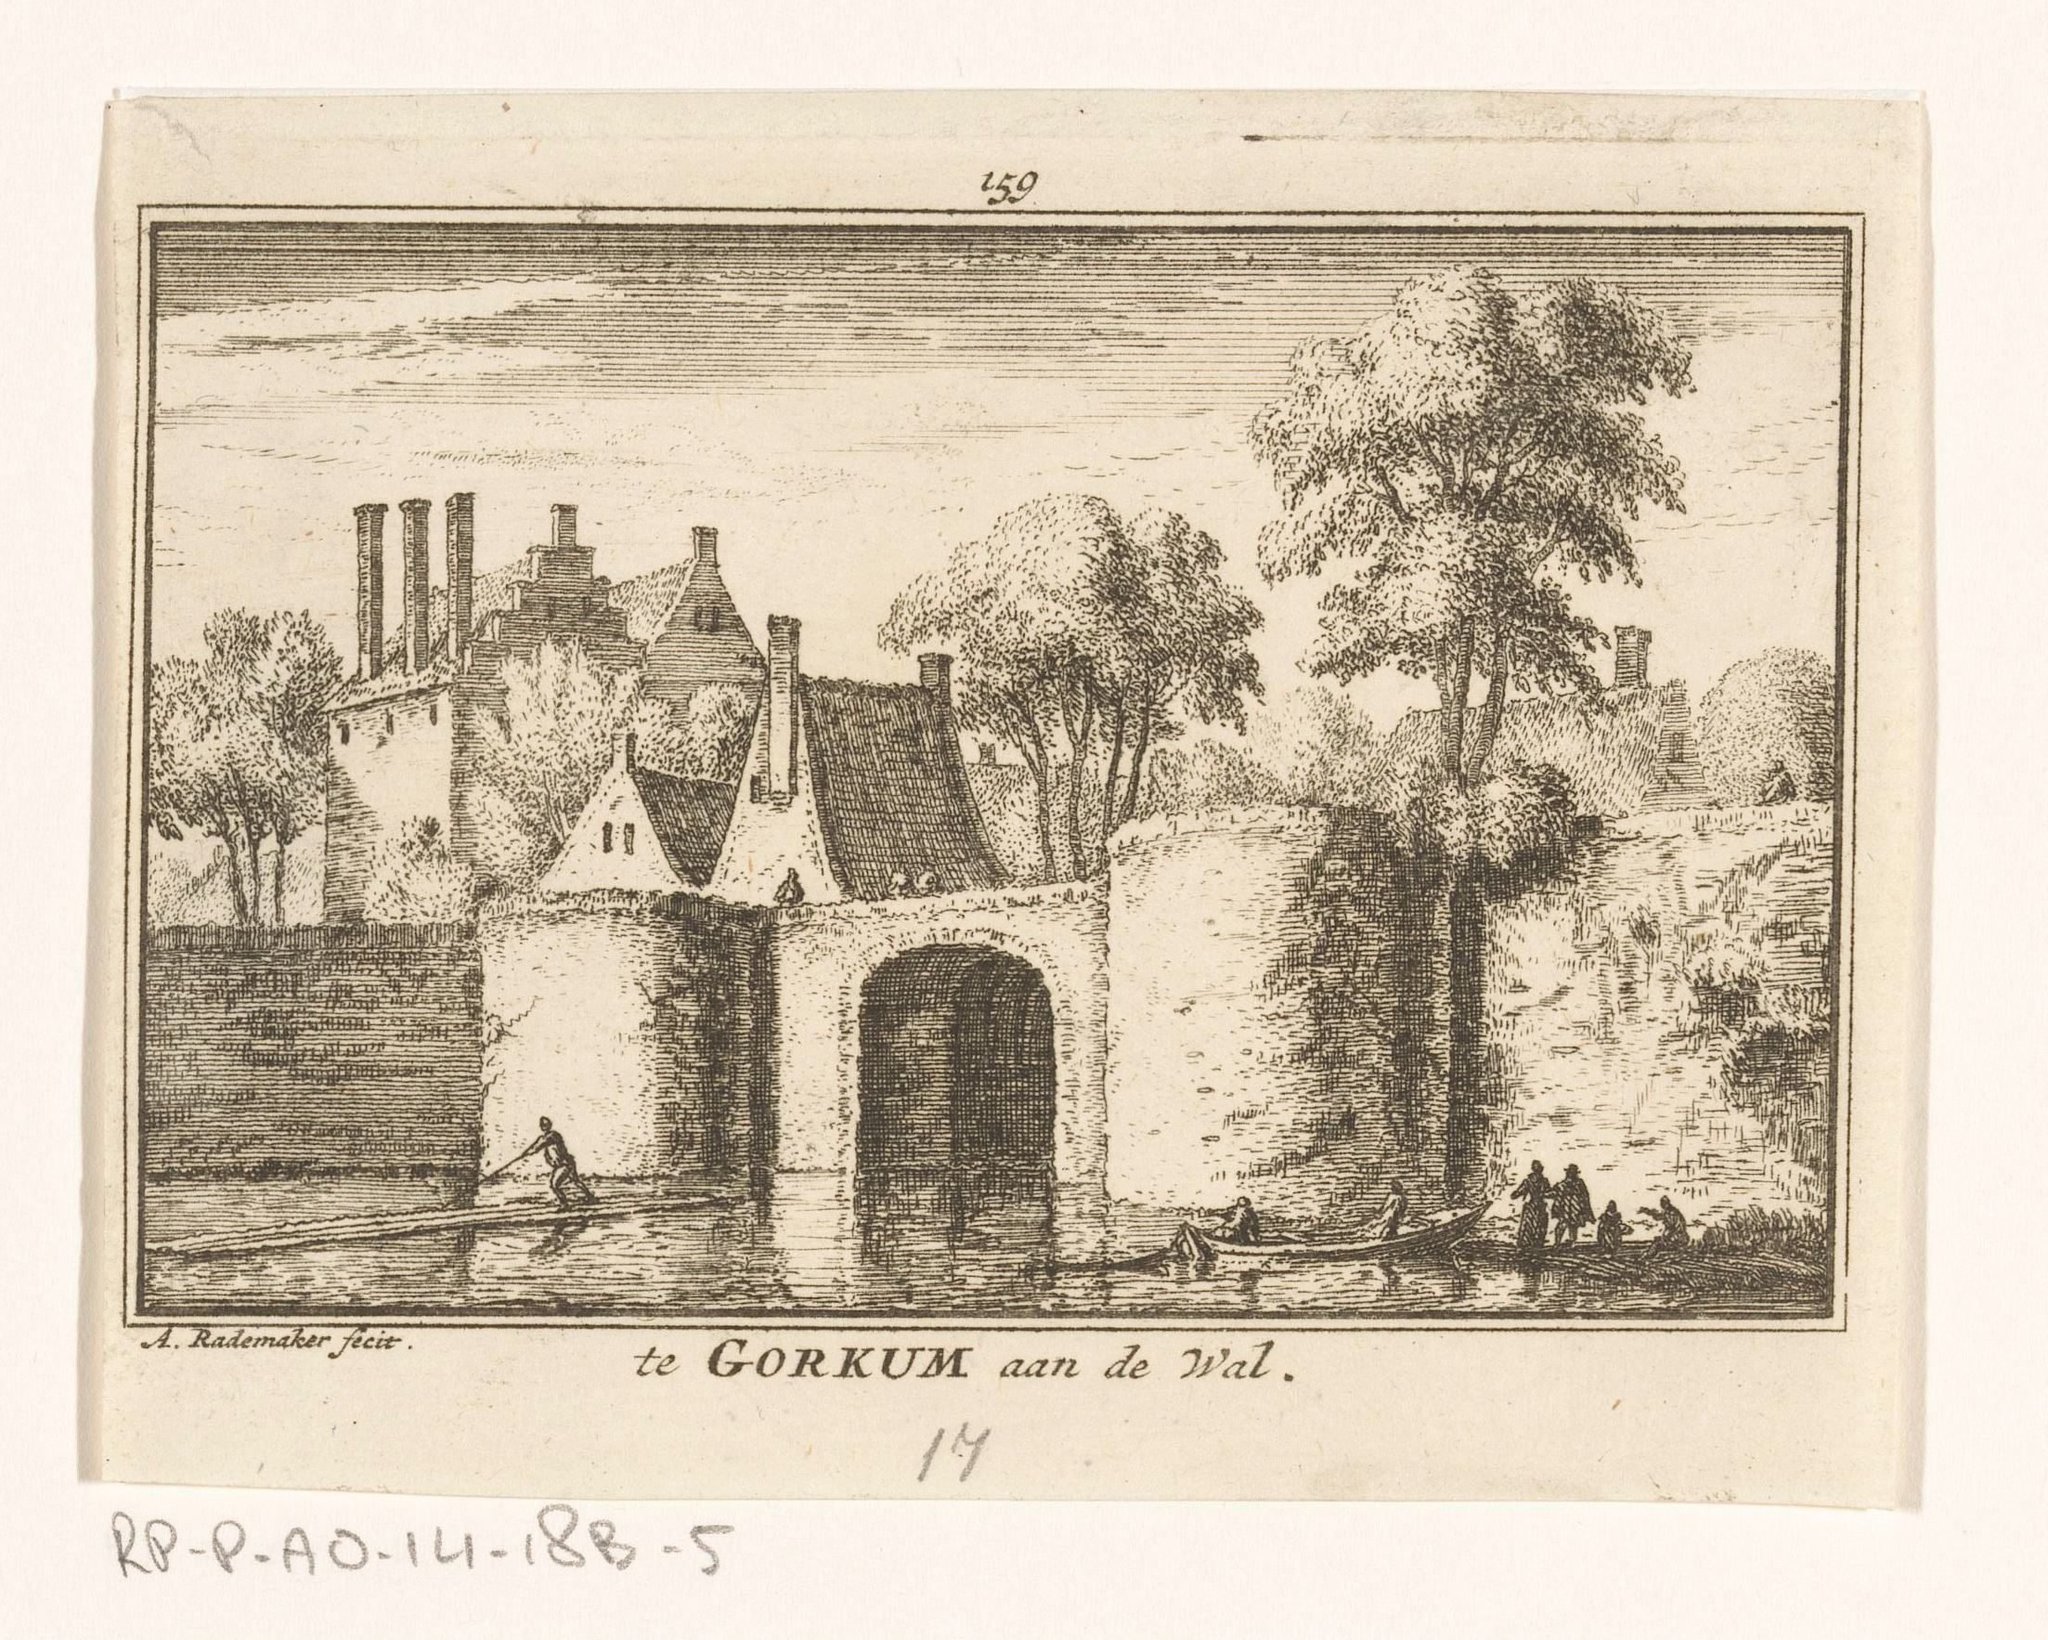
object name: book illustration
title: Gezicht op de vestingwal van Gorinchem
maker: abraham rademaker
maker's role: draughtsman, print maker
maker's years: 1676-1735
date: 1725-1803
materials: paper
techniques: engraving, etching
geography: amsterdam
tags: rowing-boat, canoe, etc., city-walls, walls ~ fortified city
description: Prent ook gebruikt in: Rademaker, Abraham. Kabinet van Nederlandsche outheden en gezichten: vervat in 300 konstplaaten (…). 2 delen. Amsterdam: Willem Barents, 1725, dl. 2, ill. 159. Na 1725 is deze prent nog in verschillende heruitgaven verschenen, uitgegeven in 1727-1733, 1770-1771 en 1792-1803. Uit welke uitgave het huidige exemplaar precies komt is niet na te gaan.